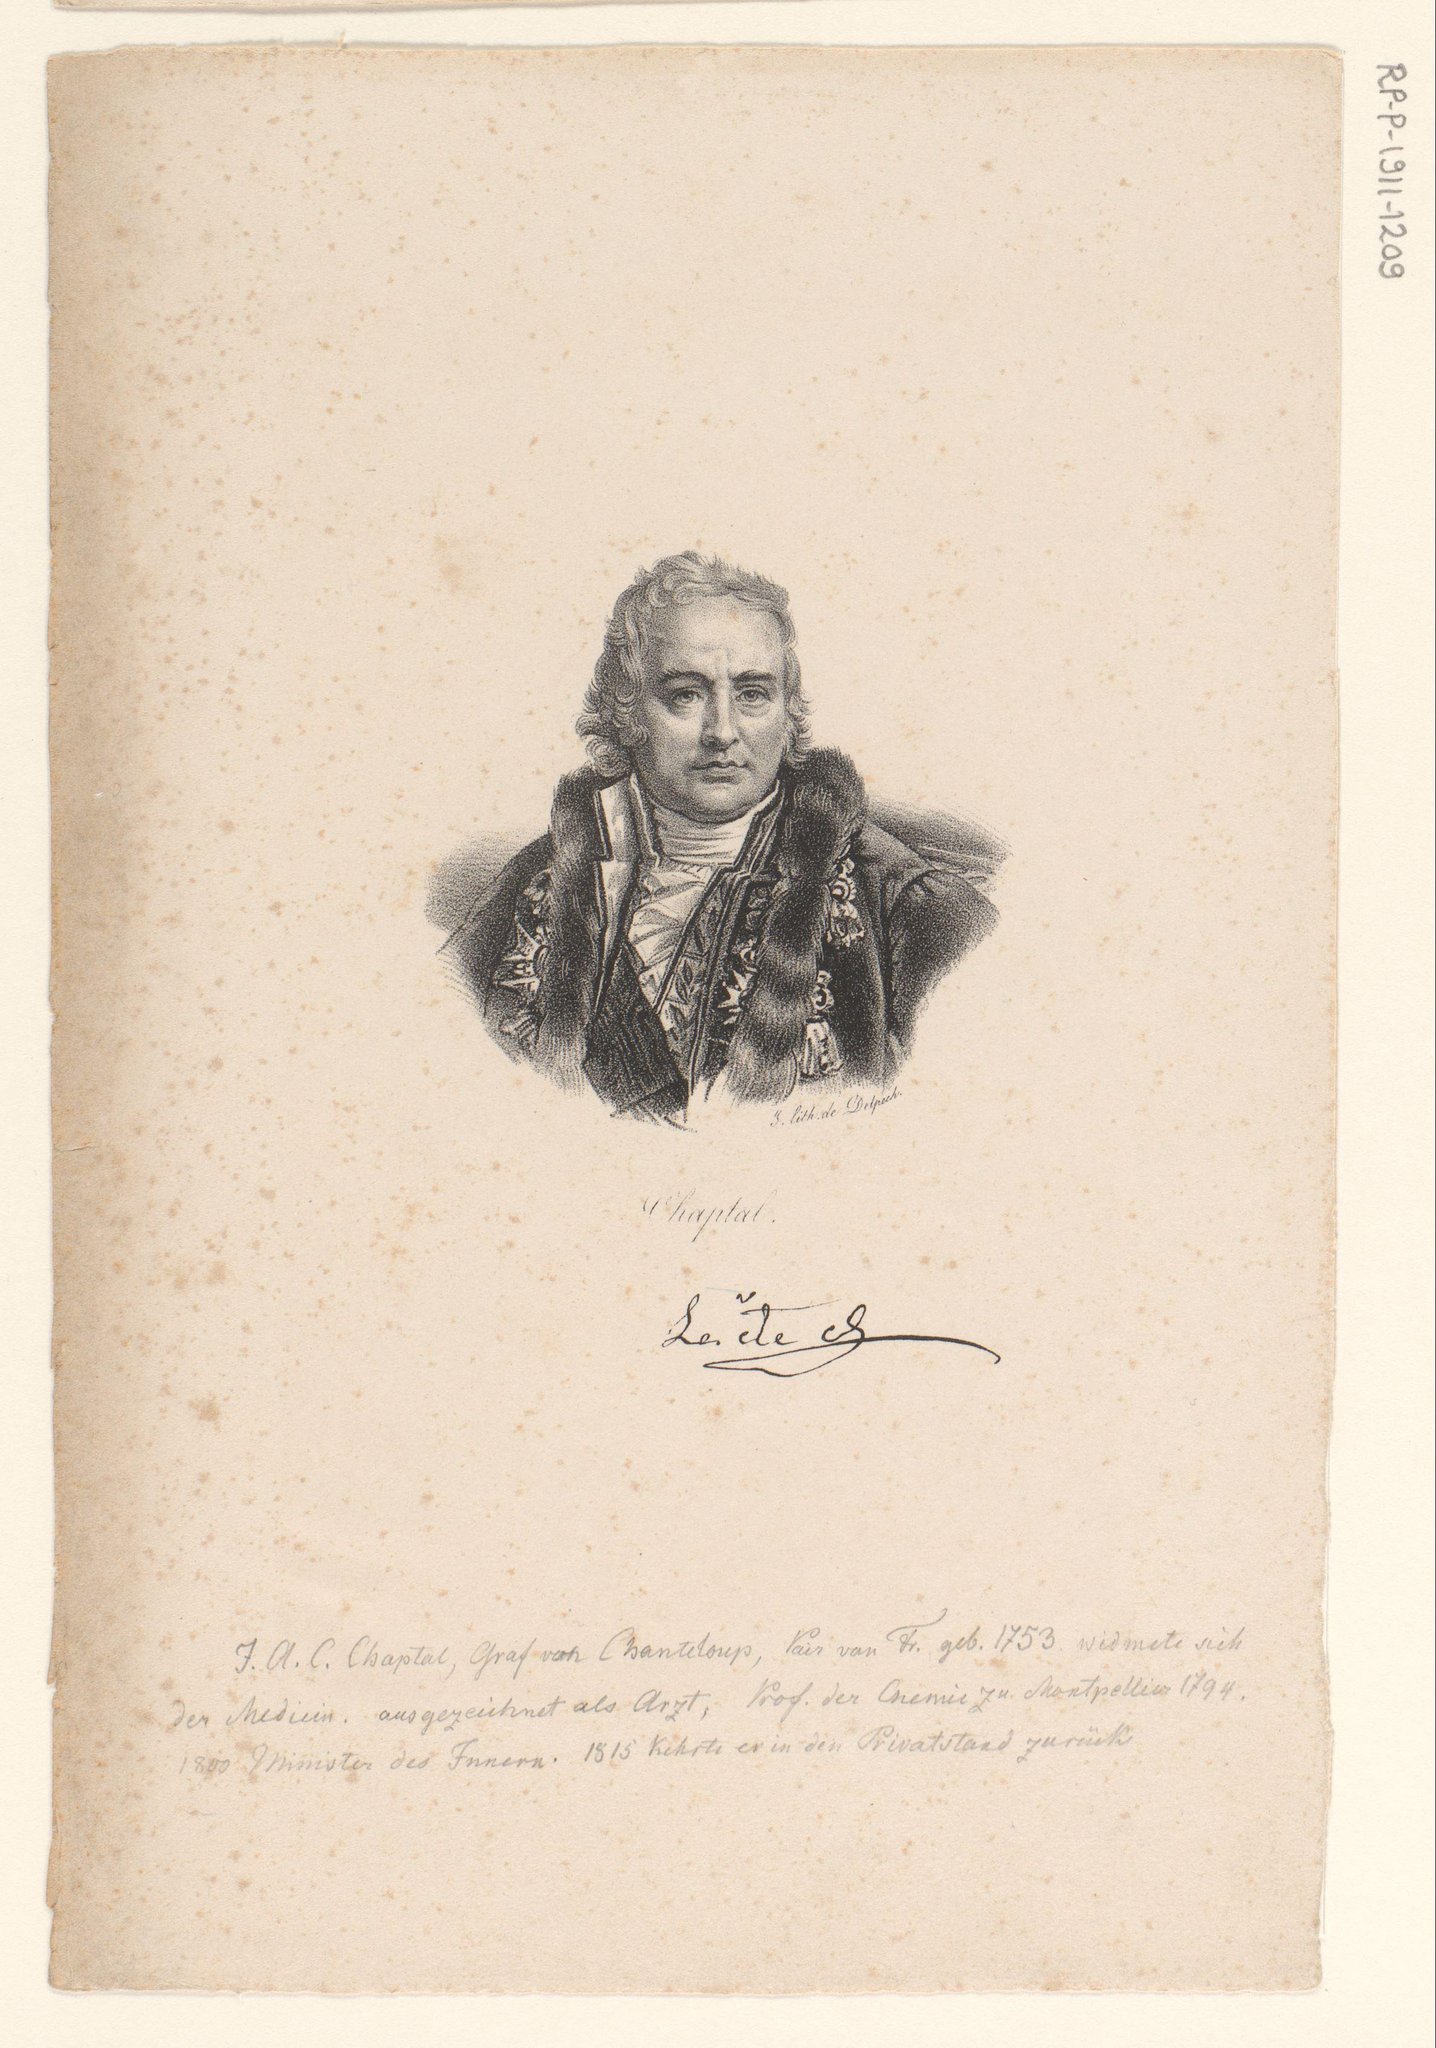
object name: print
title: Portret van Jean-Antoine Chaptal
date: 1818-1842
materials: paper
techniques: lithograph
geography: paris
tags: paris, politician, jean-antoine chaptal, historical persons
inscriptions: collector's mark: Lugt 2228a